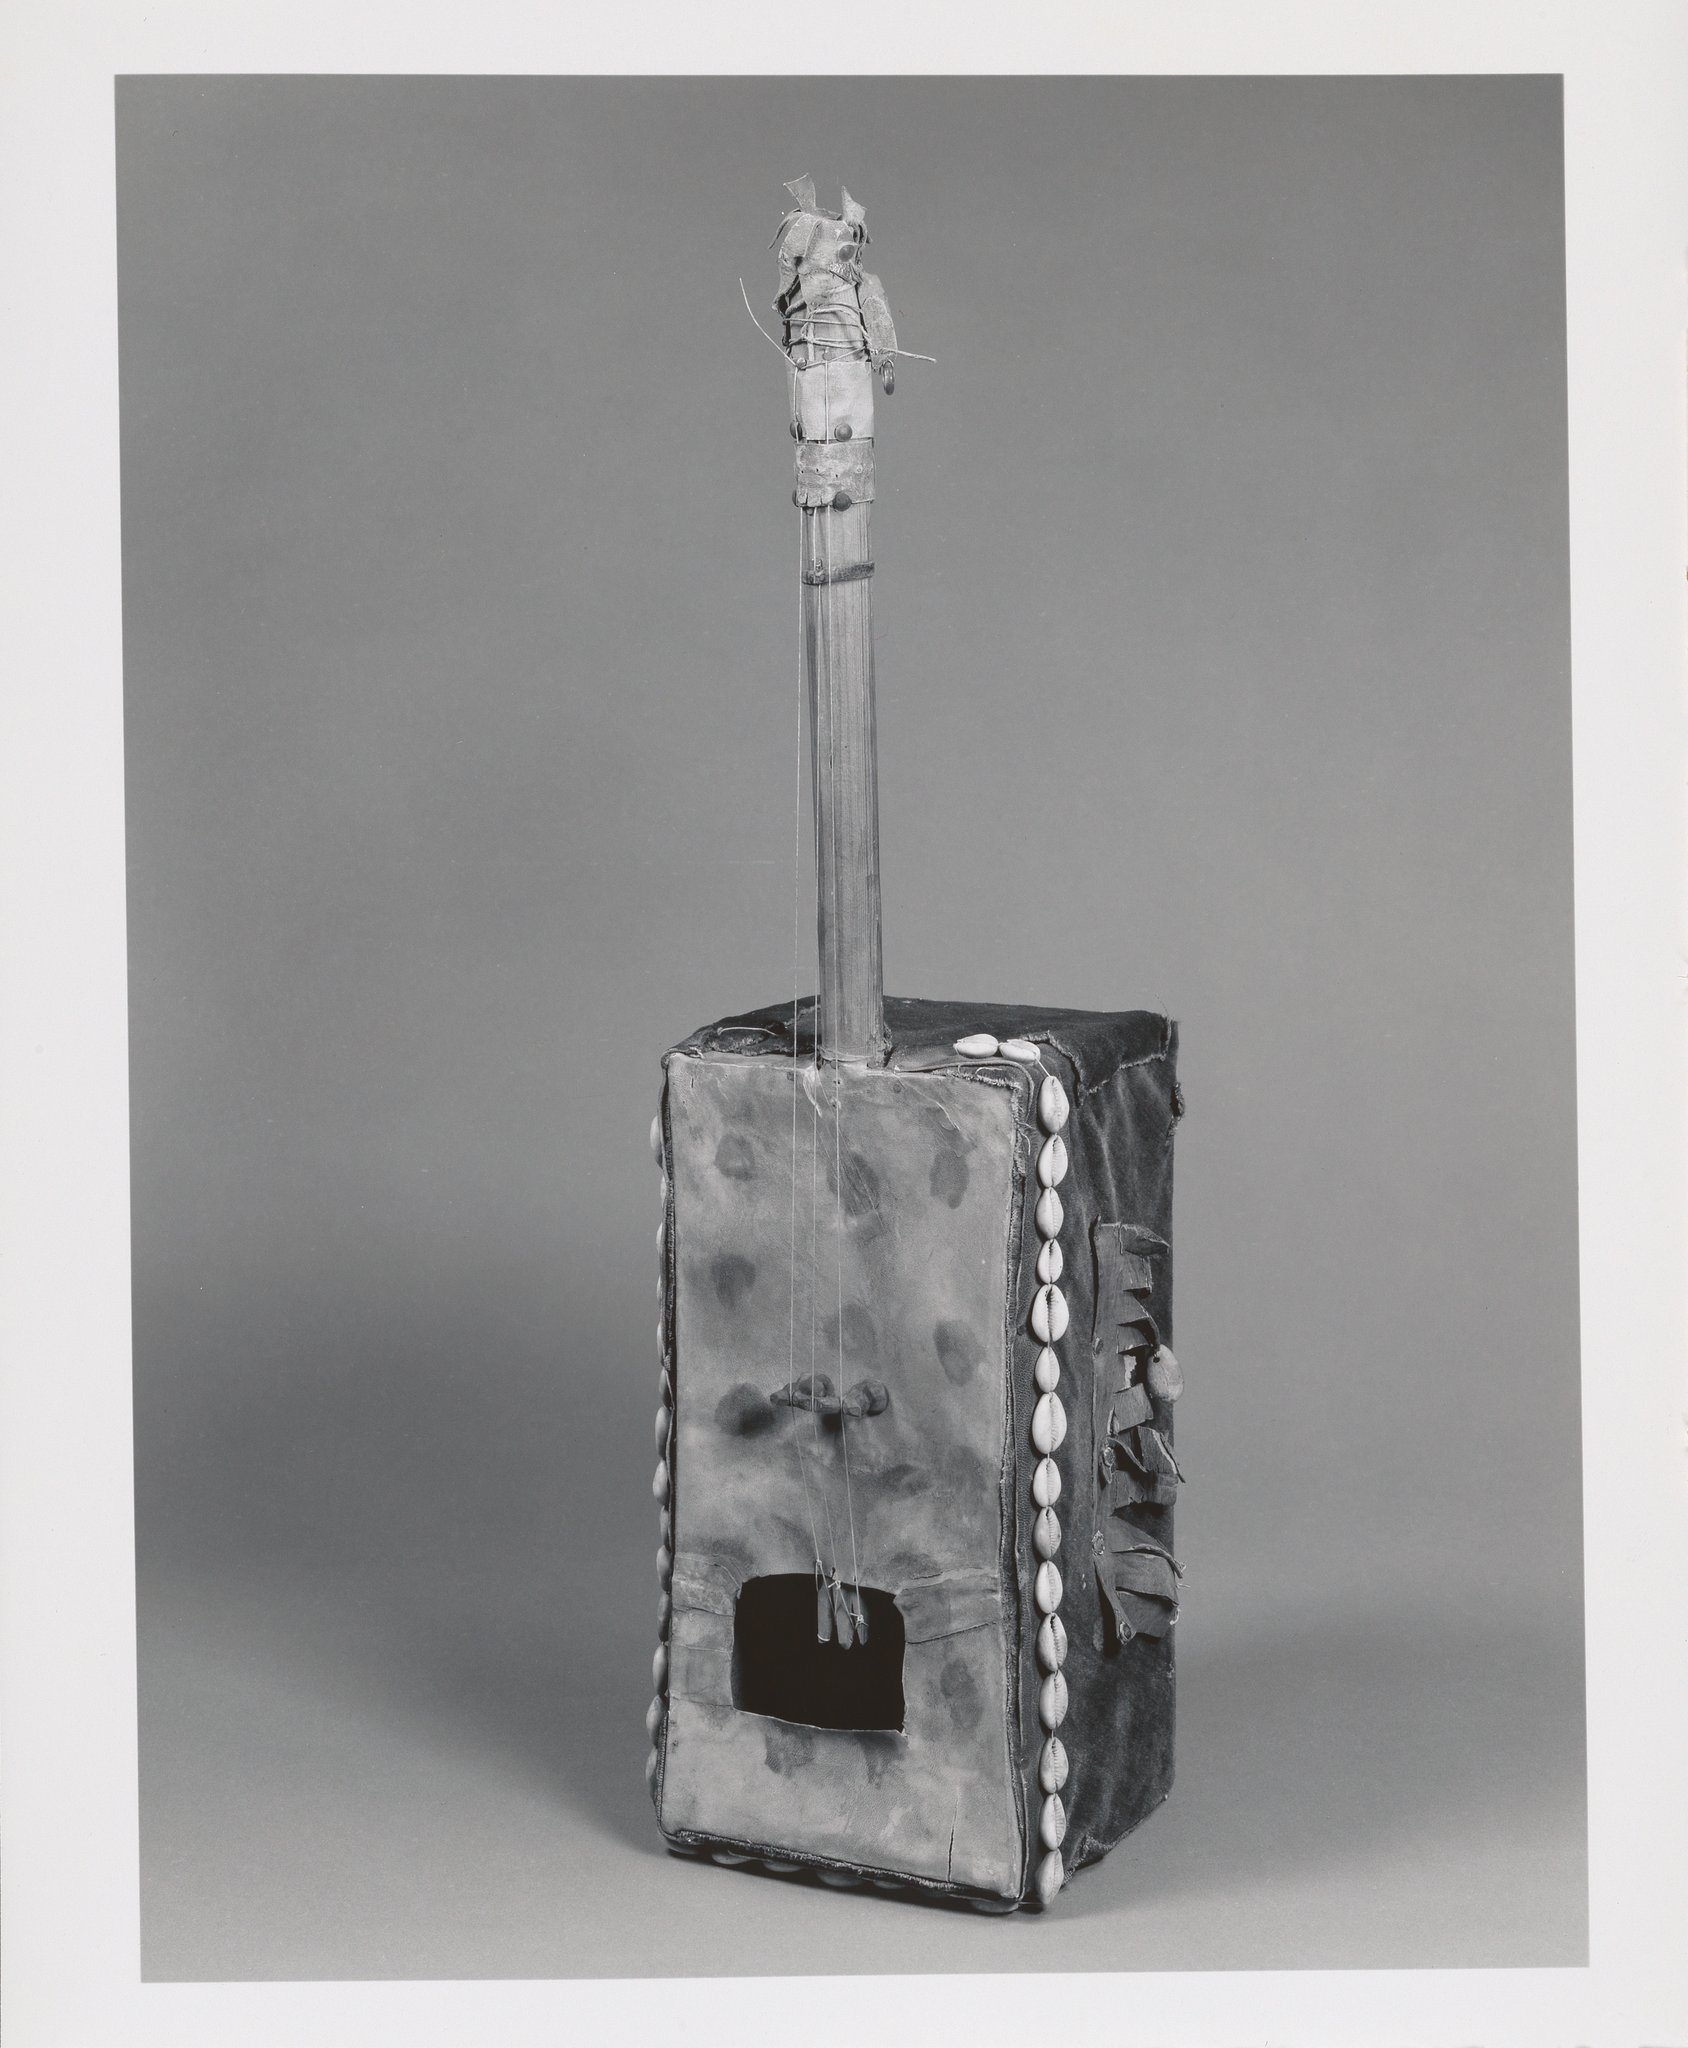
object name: guinbri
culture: sudanese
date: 1801-1900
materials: skin, wood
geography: sudan